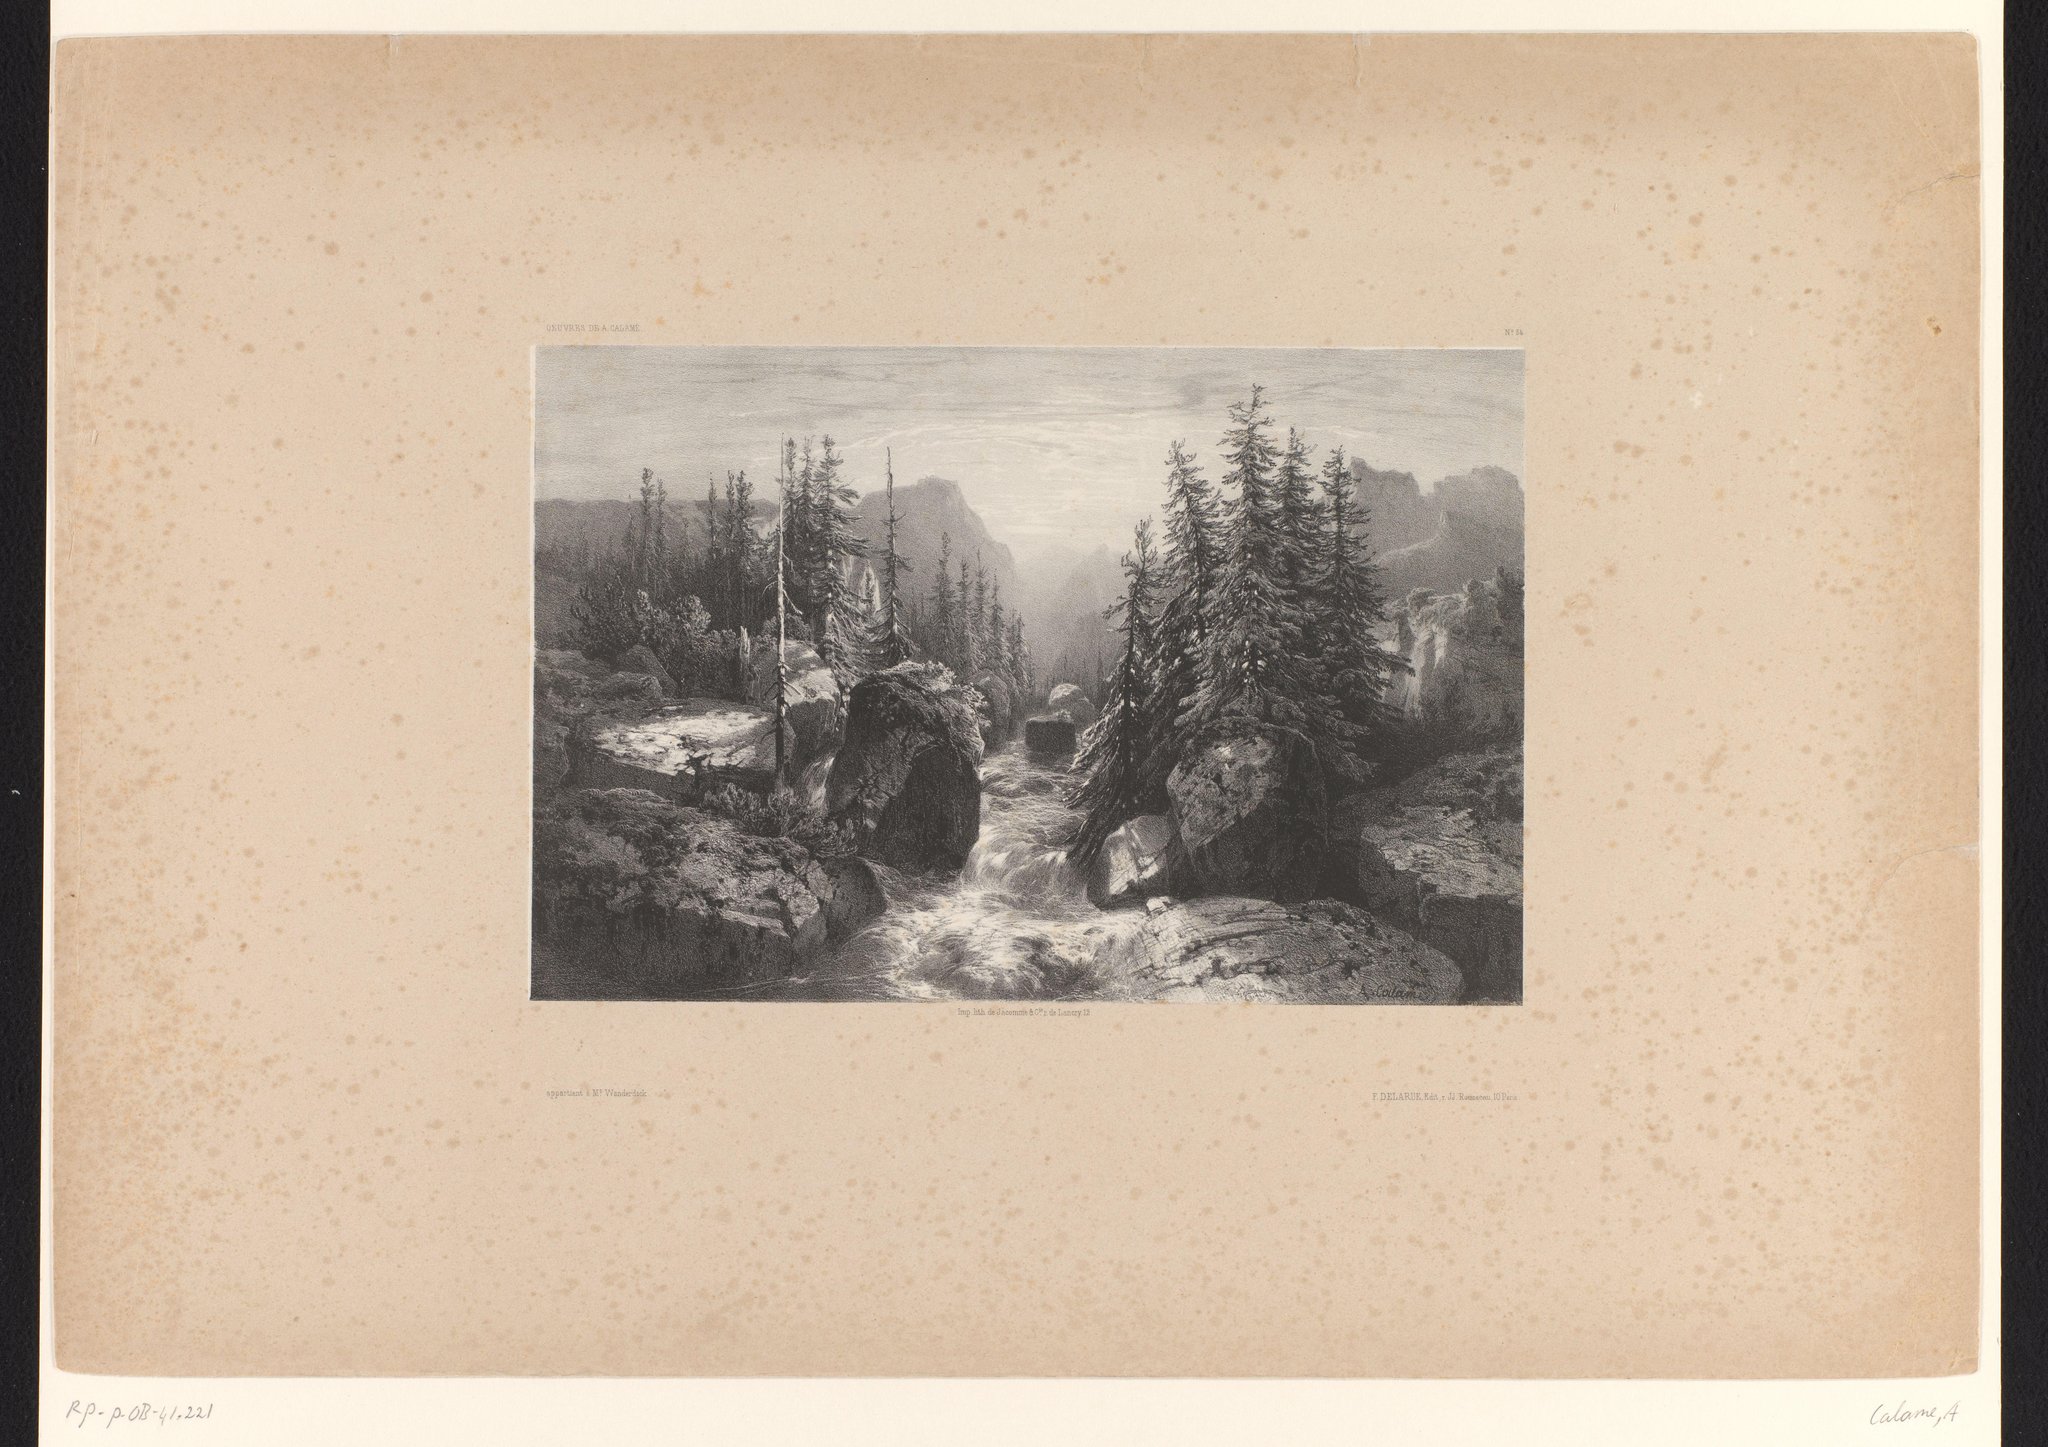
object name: print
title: Stroom van de Reichenbach bij de Scheidegg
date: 1852-1855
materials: paper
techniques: lithograph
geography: paris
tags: trees, brook, mountains